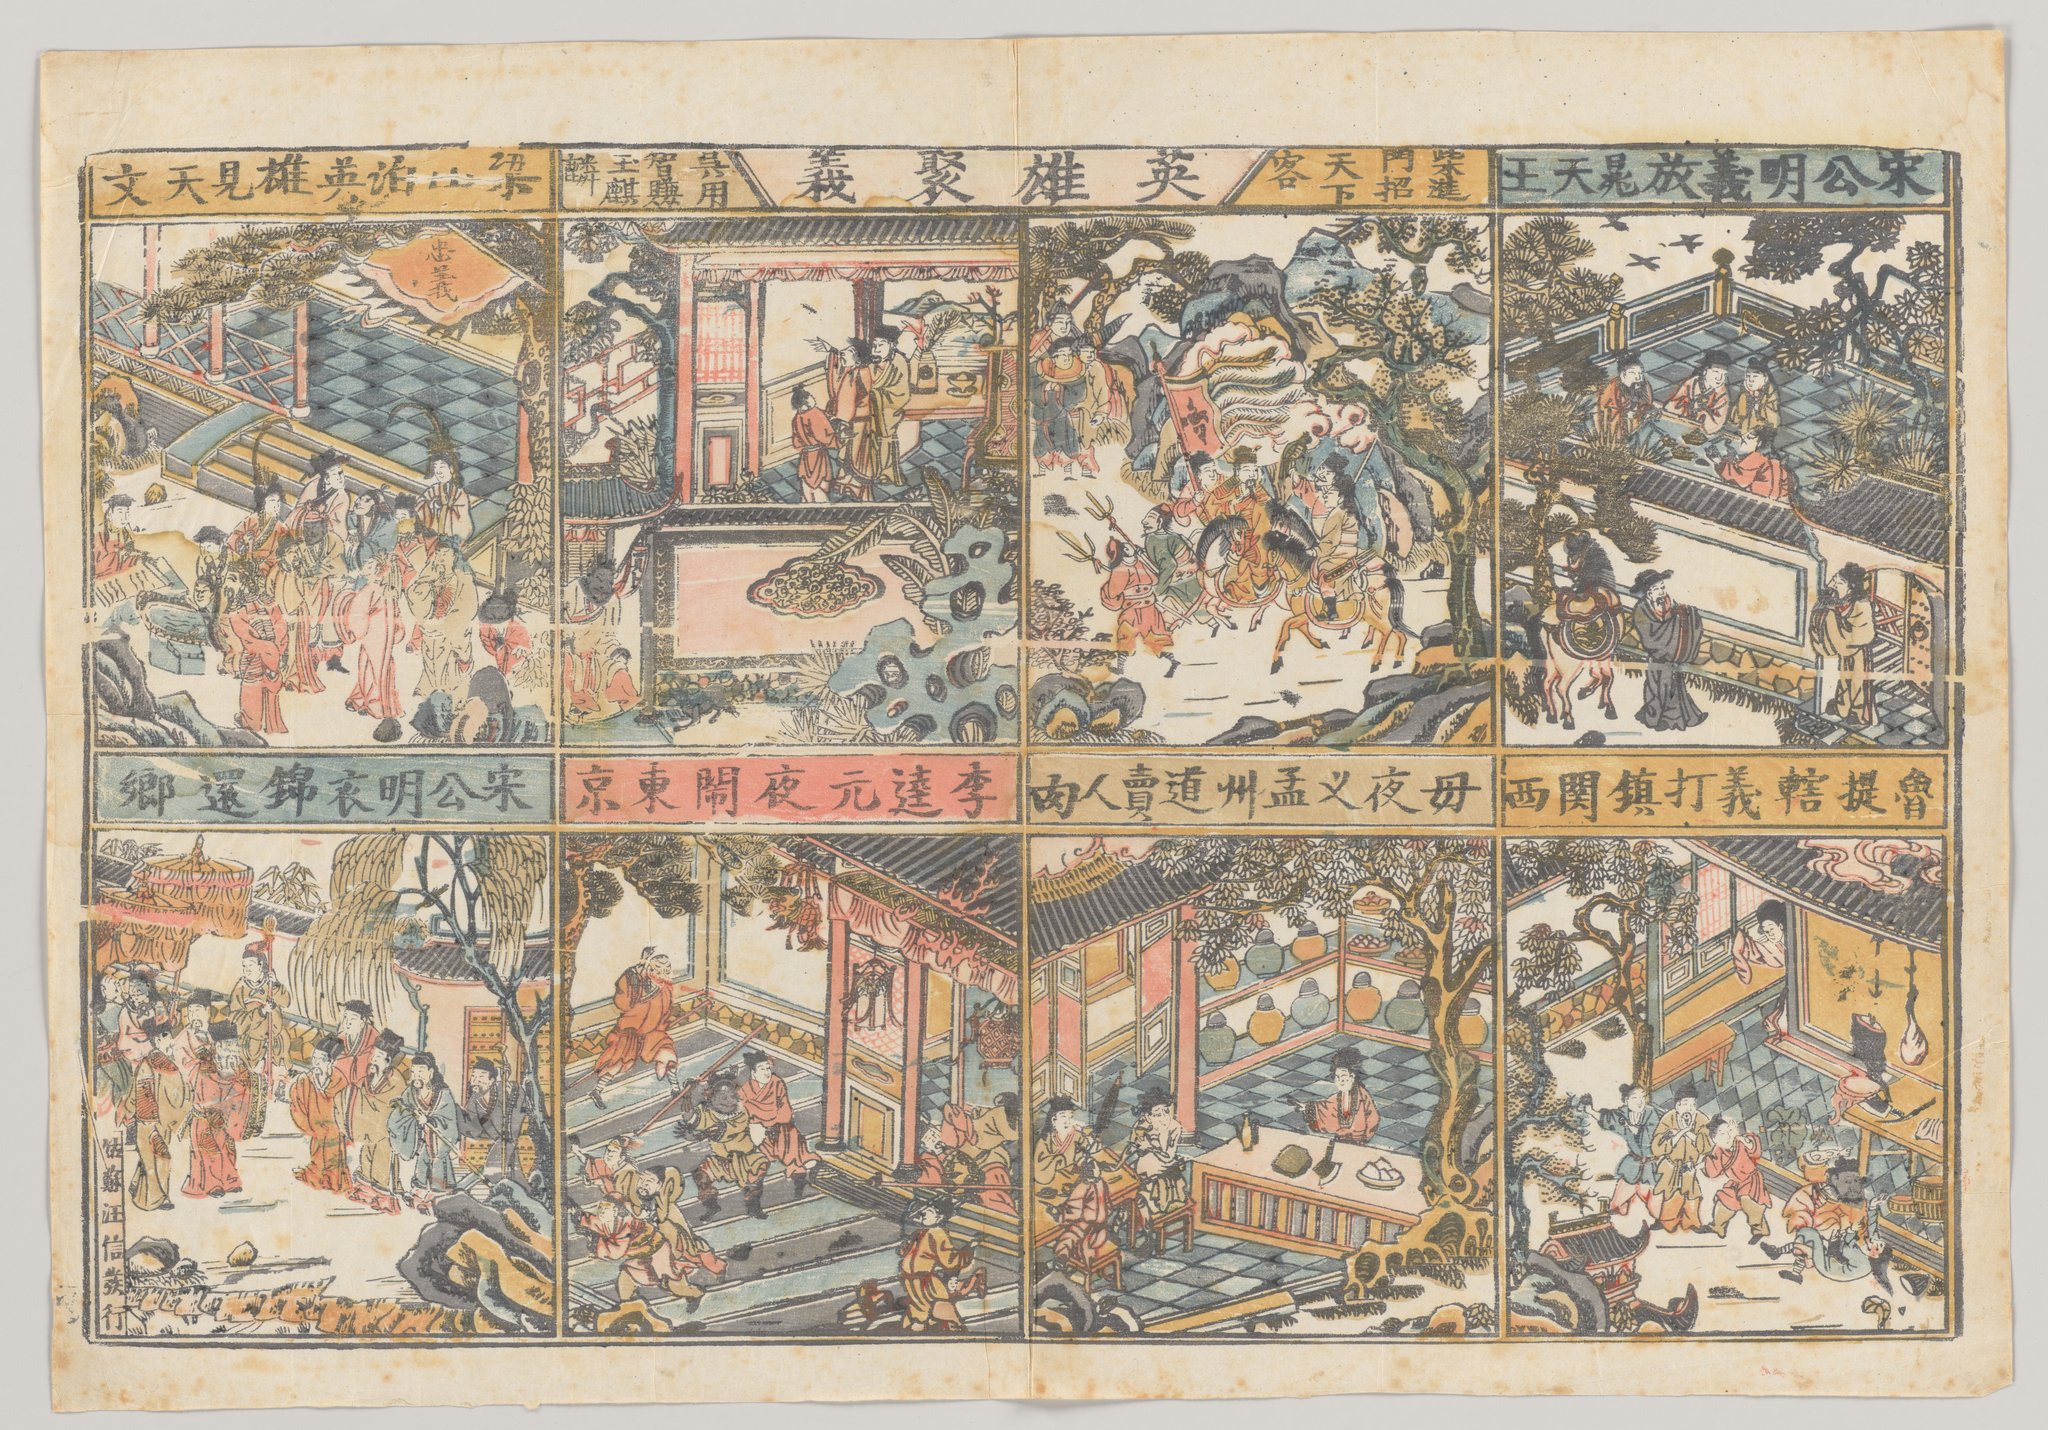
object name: print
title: Reunion of the Heroes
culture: chinese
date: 1662-1722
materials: ink, paper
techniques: hand coloring, woodblock print